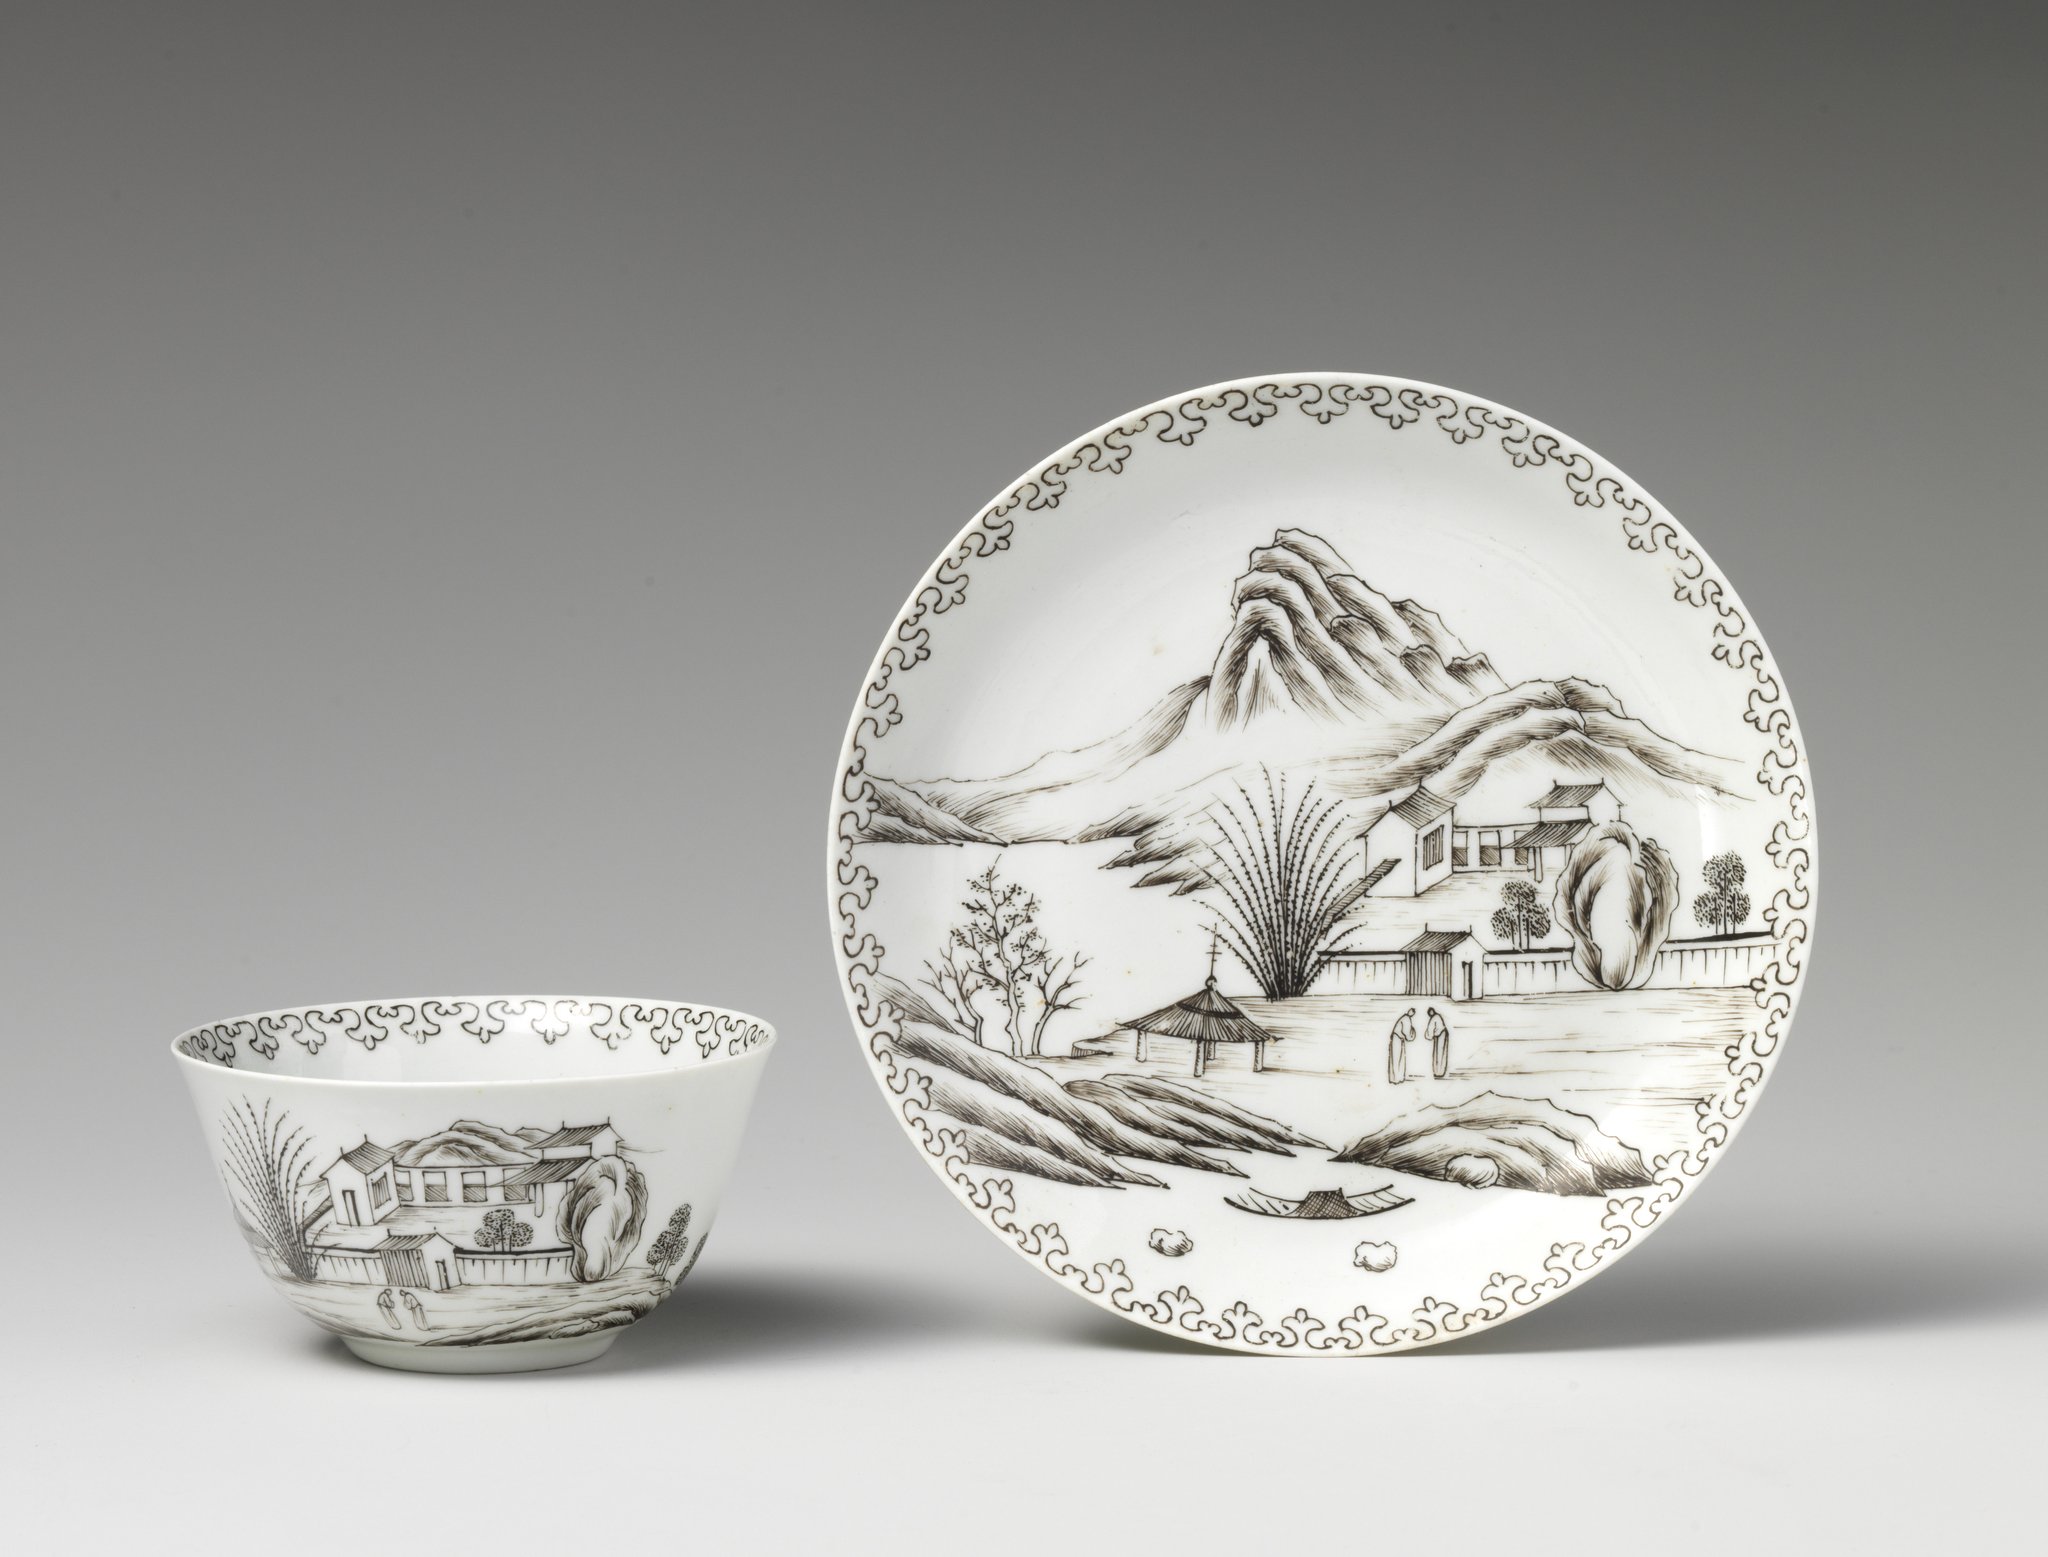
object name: teabowl and saucer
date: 1701-1800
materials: soft paste porcelain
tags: houses,mountains,landscapes